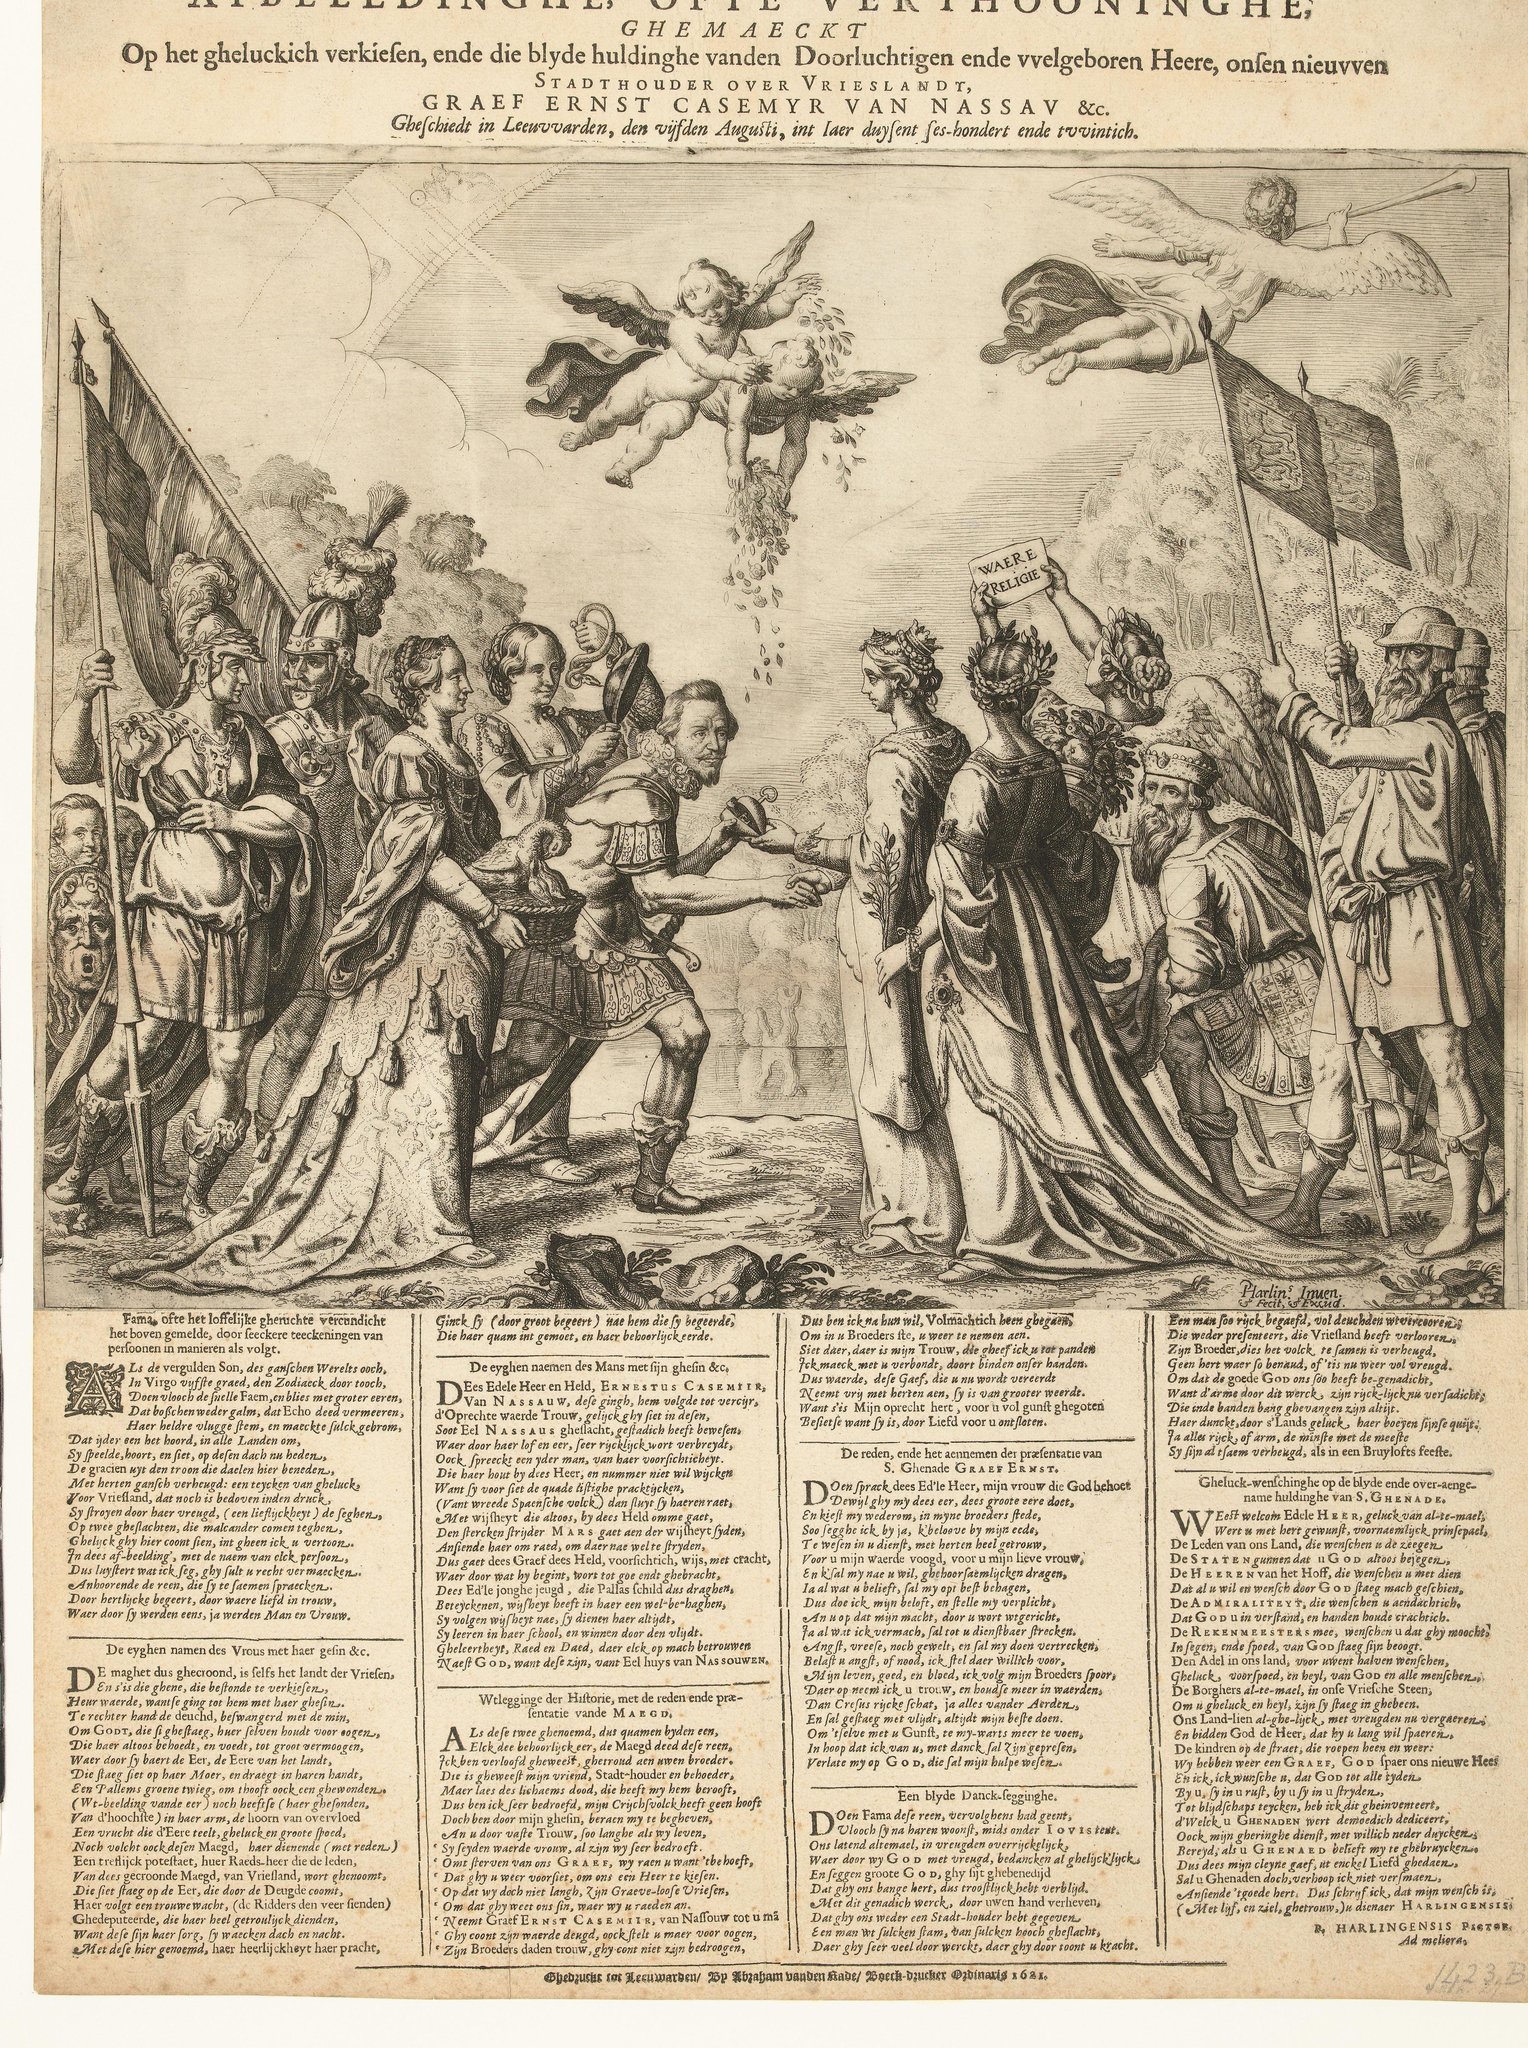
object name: print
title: Allegorie op de installatie van Ernst Casimir, graaf van Nassau, tot stadhouder van Friesland, 1620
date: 1621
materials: paper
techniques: etching, letterpress printing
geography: amsterdam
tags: ernst casimir graaf van nassau-dietz, installation of a ruler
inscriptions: date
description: Allegorie op de installatie van Ernst Casimir, graaf van Nassau, tot stadhouder van Friesland, 5 augustus 1620. Graaf Ernst Casimir overhandigt zijn hart aan de provinciemaagd van Friesland, begeleid door Ware Religie en Overvloed door Vrede. De graaf wordt begeleid door Zelfopoffering en Voorzichtigheid, Minerva en Mars. In de lucht twee putti en de Faam. Onder de prent vastgeplakt een tekstblad met 4 kolommen tekst in het Nederlands.